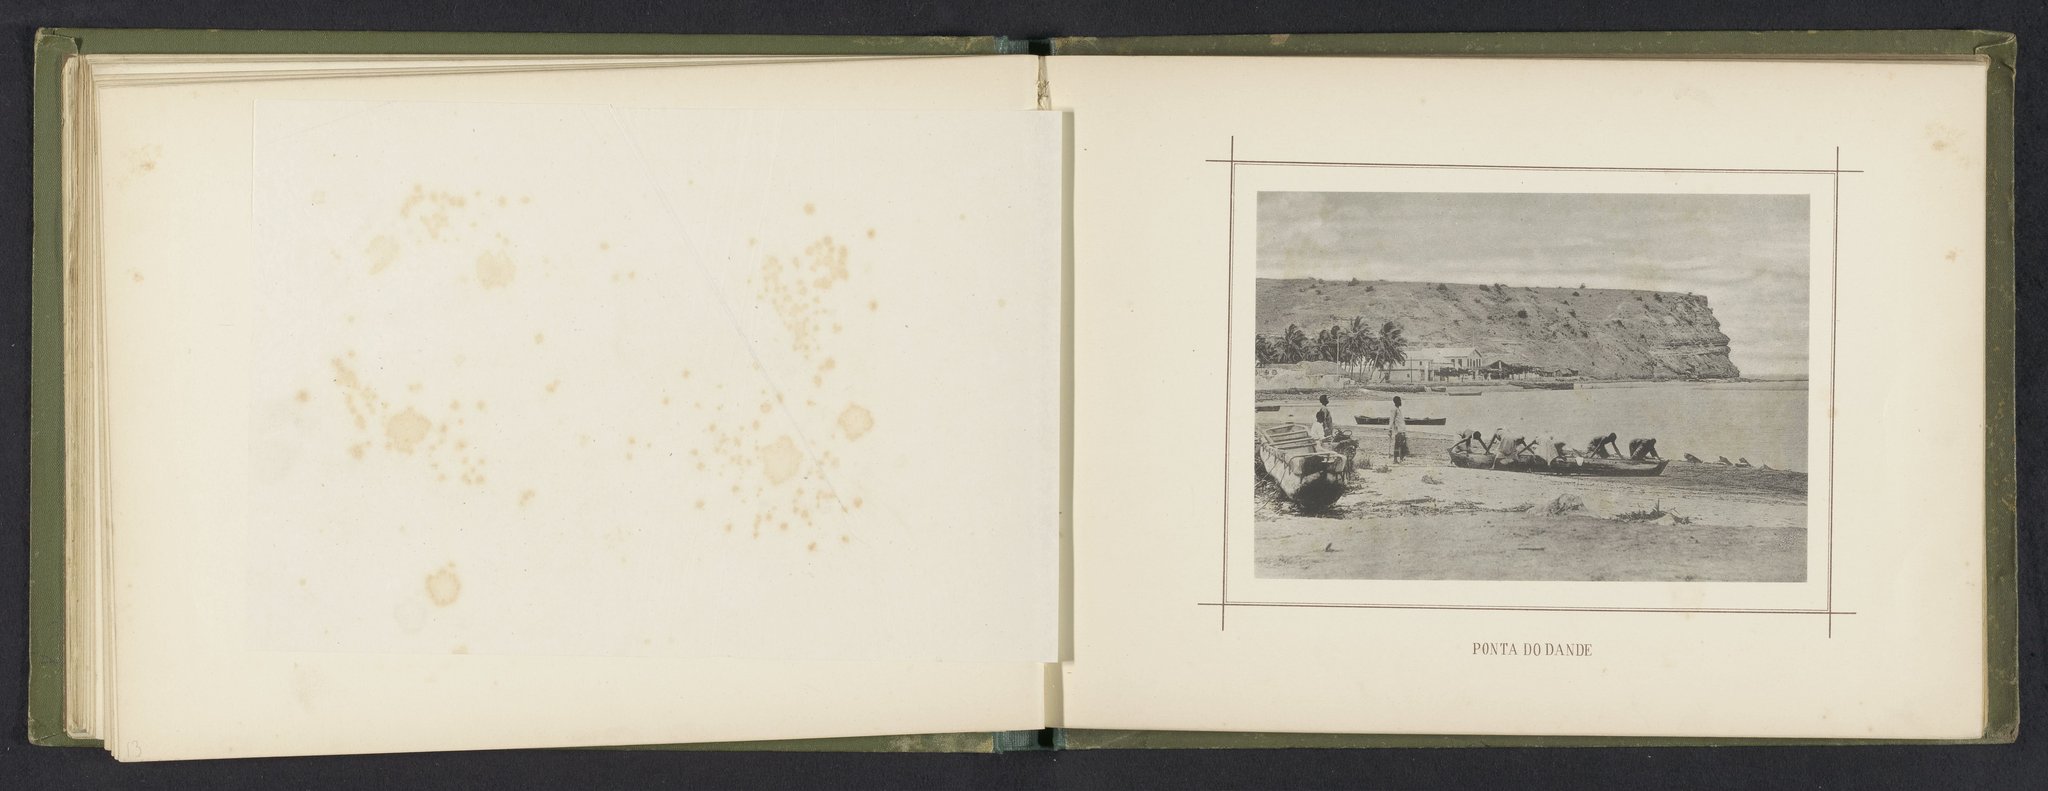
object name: page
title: Gezicht op het Ponta do Dande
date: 1876-1886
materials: paper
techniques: photograph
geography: barra do dande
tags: cape (coast)